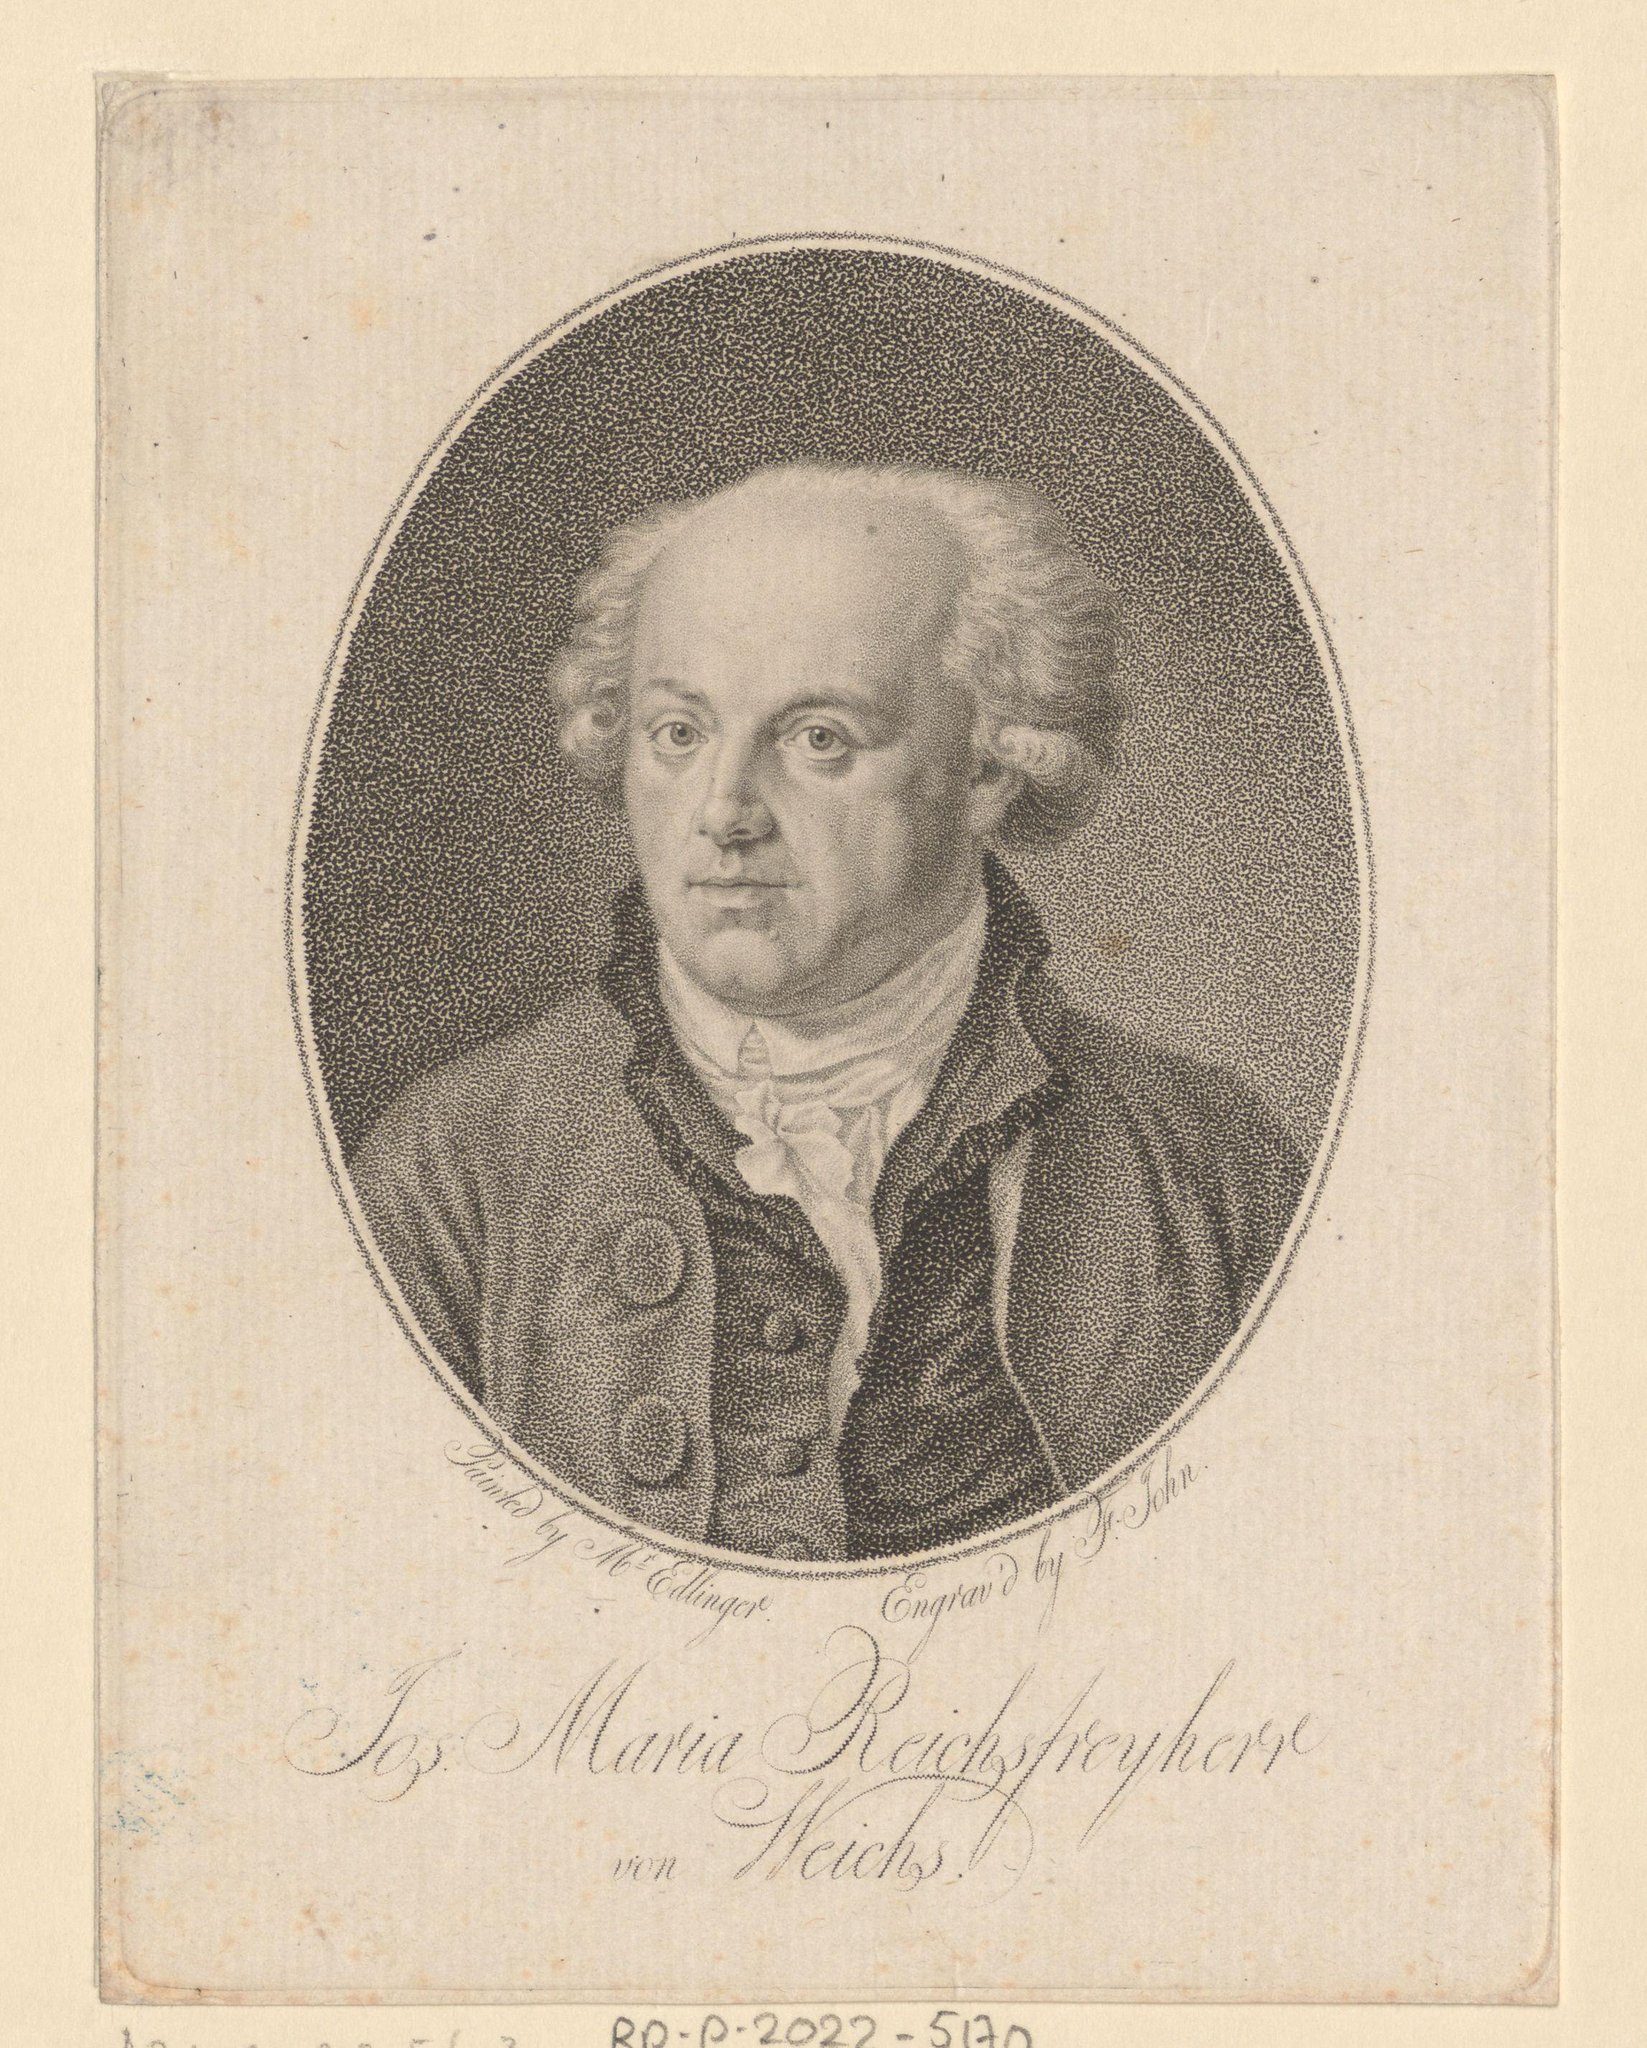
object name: print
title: Portret Joseph Maria von Weichs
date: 1800-1843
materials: paper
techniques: etching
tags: historical persons, lawyer, attorney at law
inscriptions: collector's mark: Lugt 3280